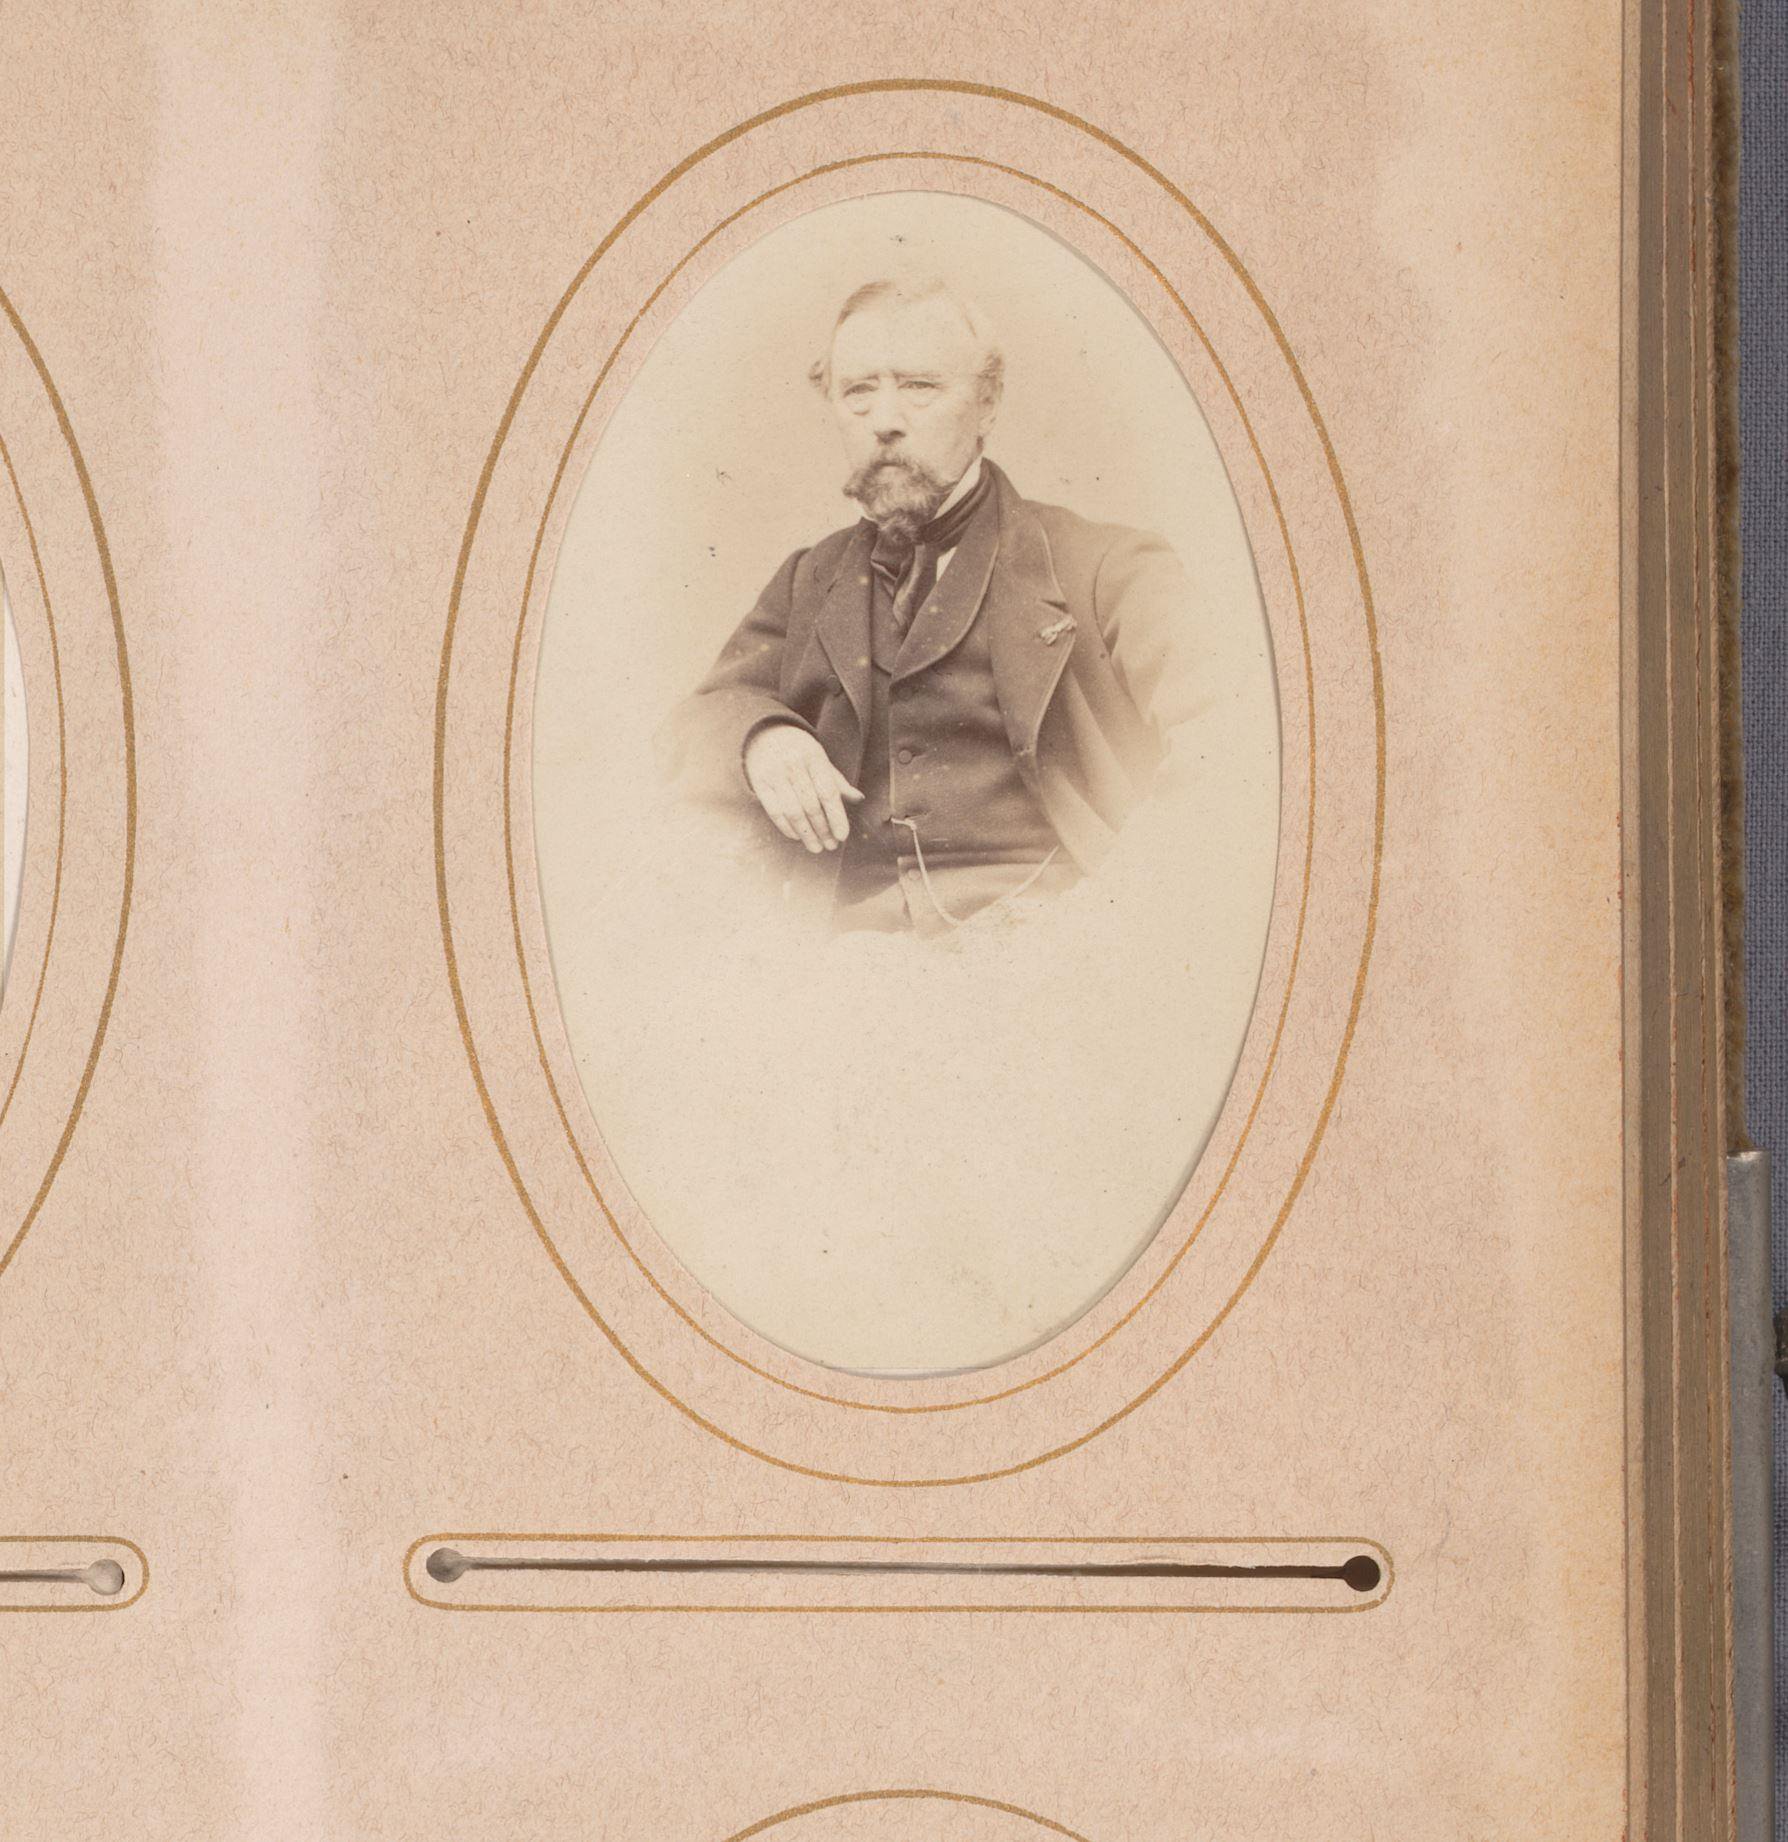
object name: photograph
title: Portret van een man met baard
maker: albert greiner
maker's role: fotograaf, fotostudio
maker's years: 1833-1890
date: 1861-1874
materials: cardboard, photographic support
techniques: albumen print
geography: amsterdam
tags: historical persons, beard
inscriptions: inscription: ‘A. Greiner/ Photograf/ Nieuwendijk L.87/ Amsterdam’